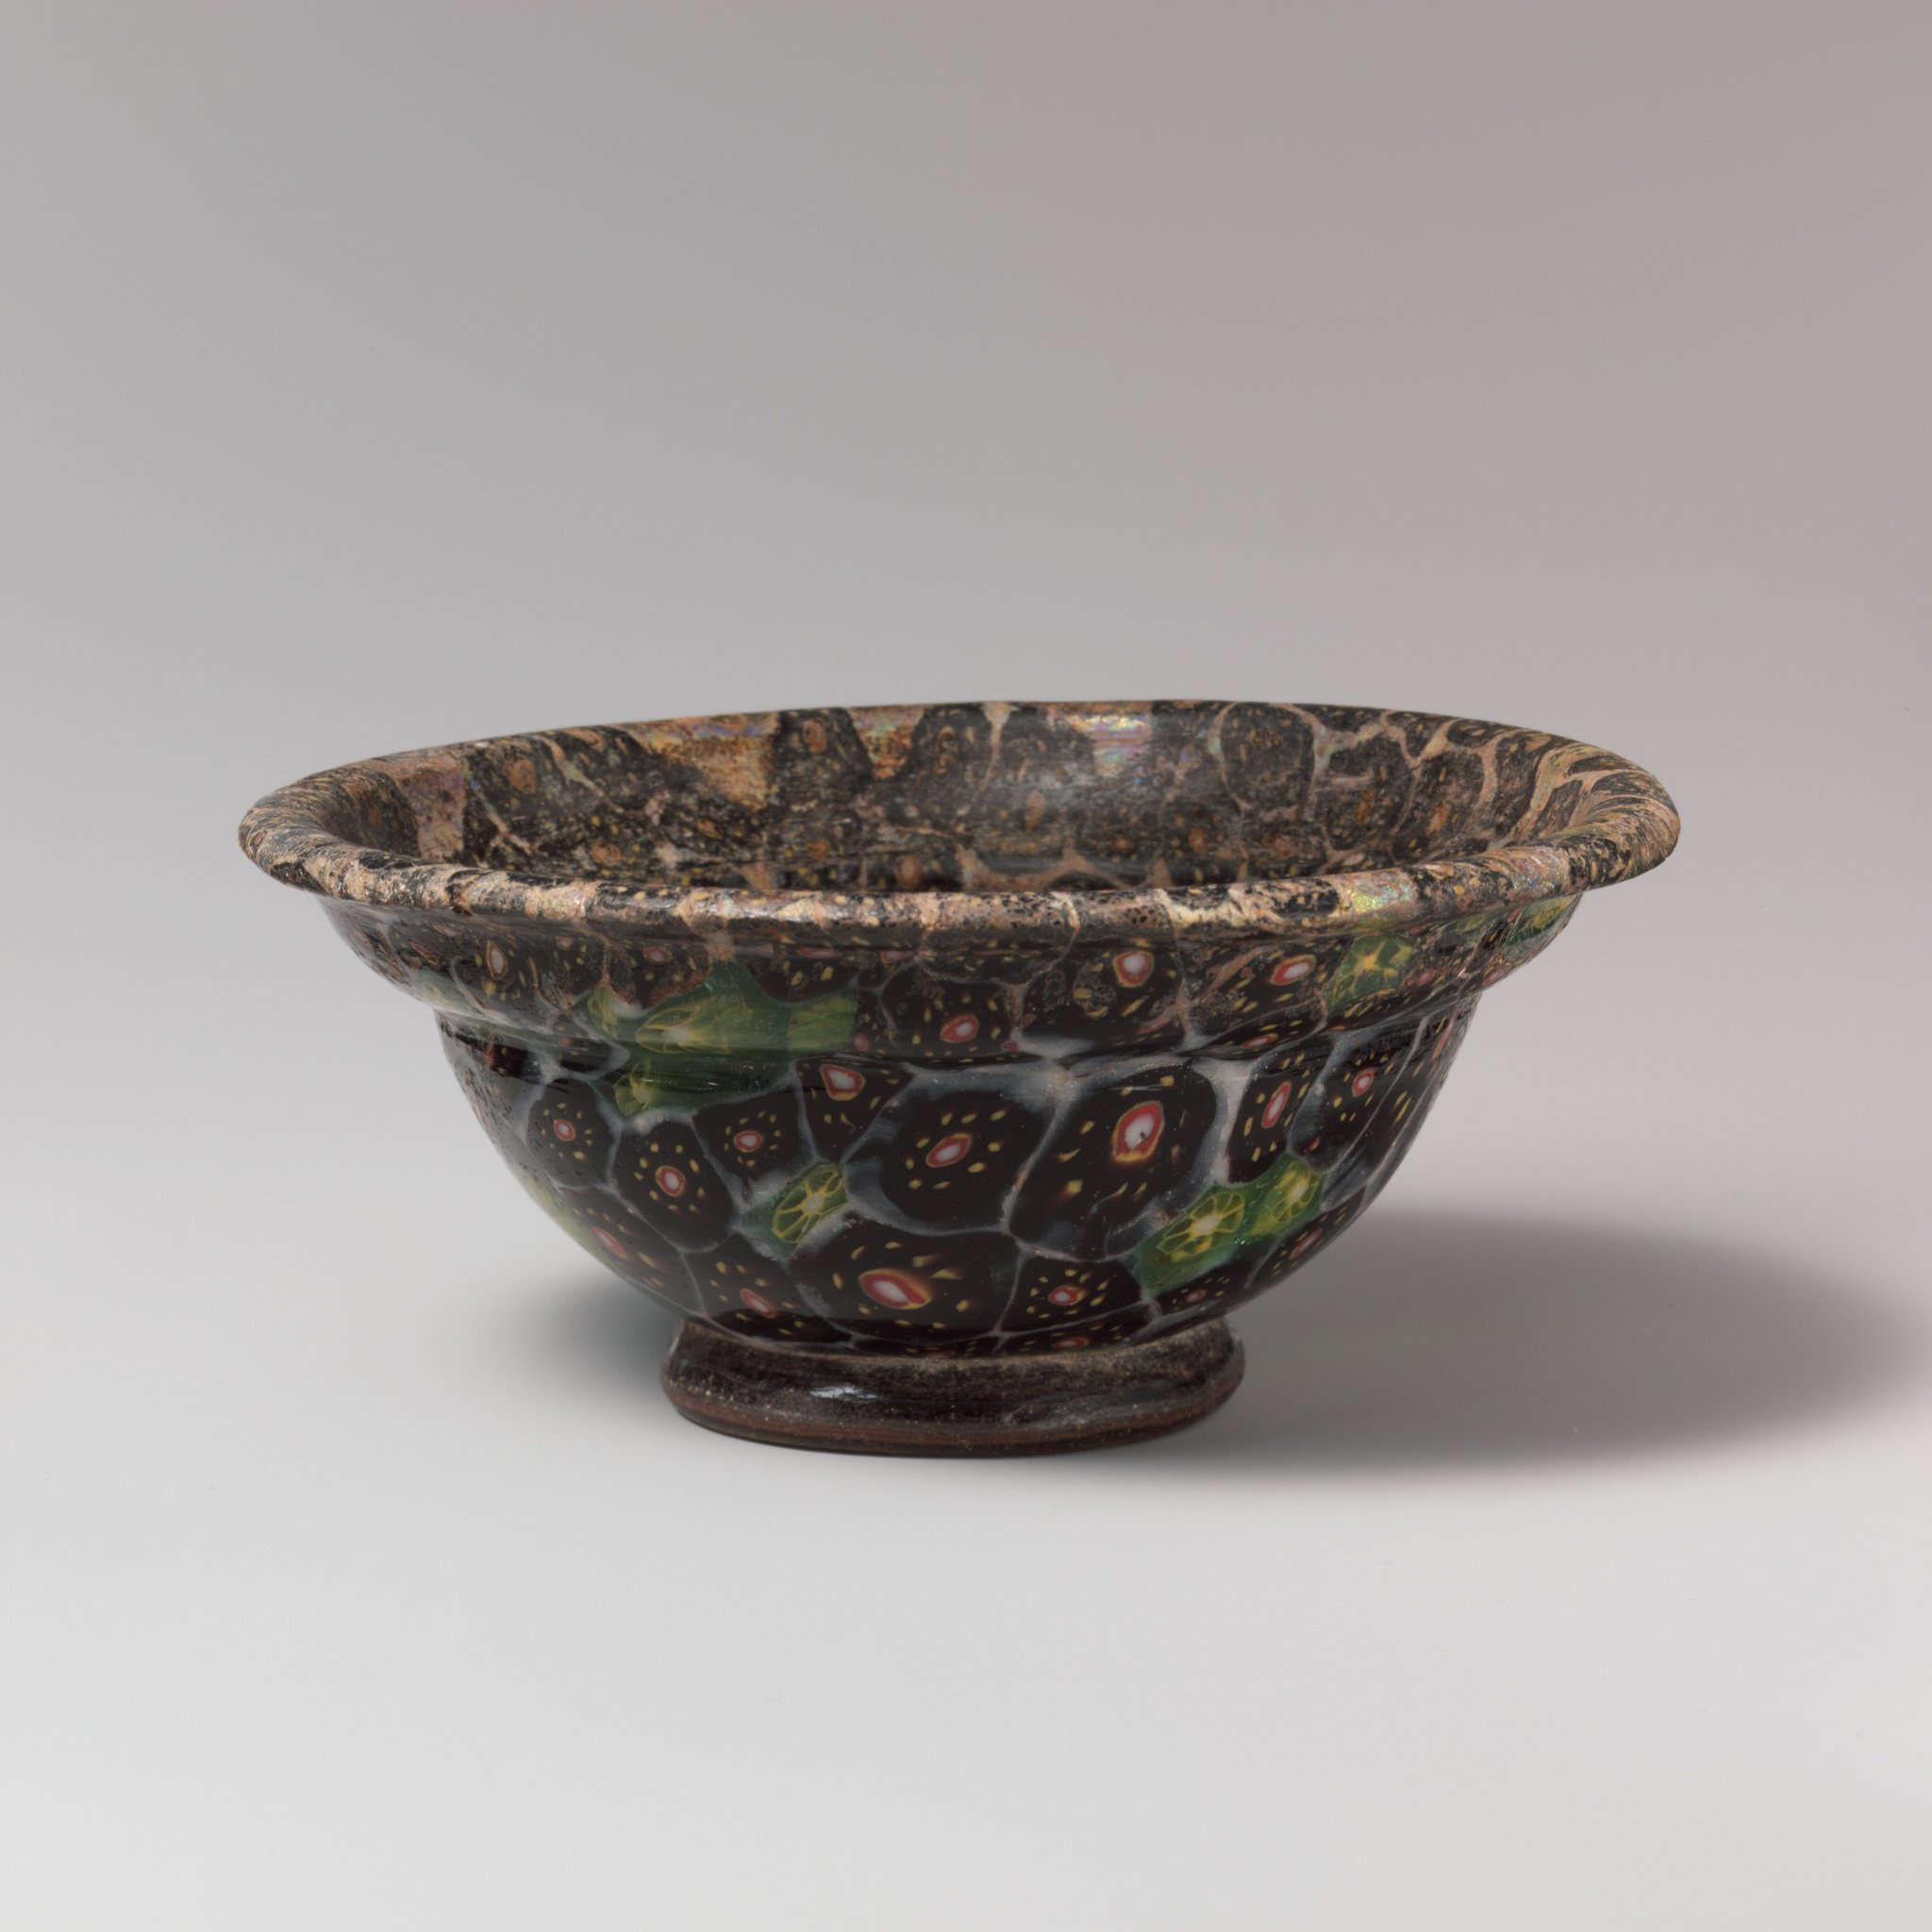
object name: bowl, mosaic, patella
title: Glass mosaic carinated bowl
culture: roman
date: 34 BCE-33 CE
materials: glass